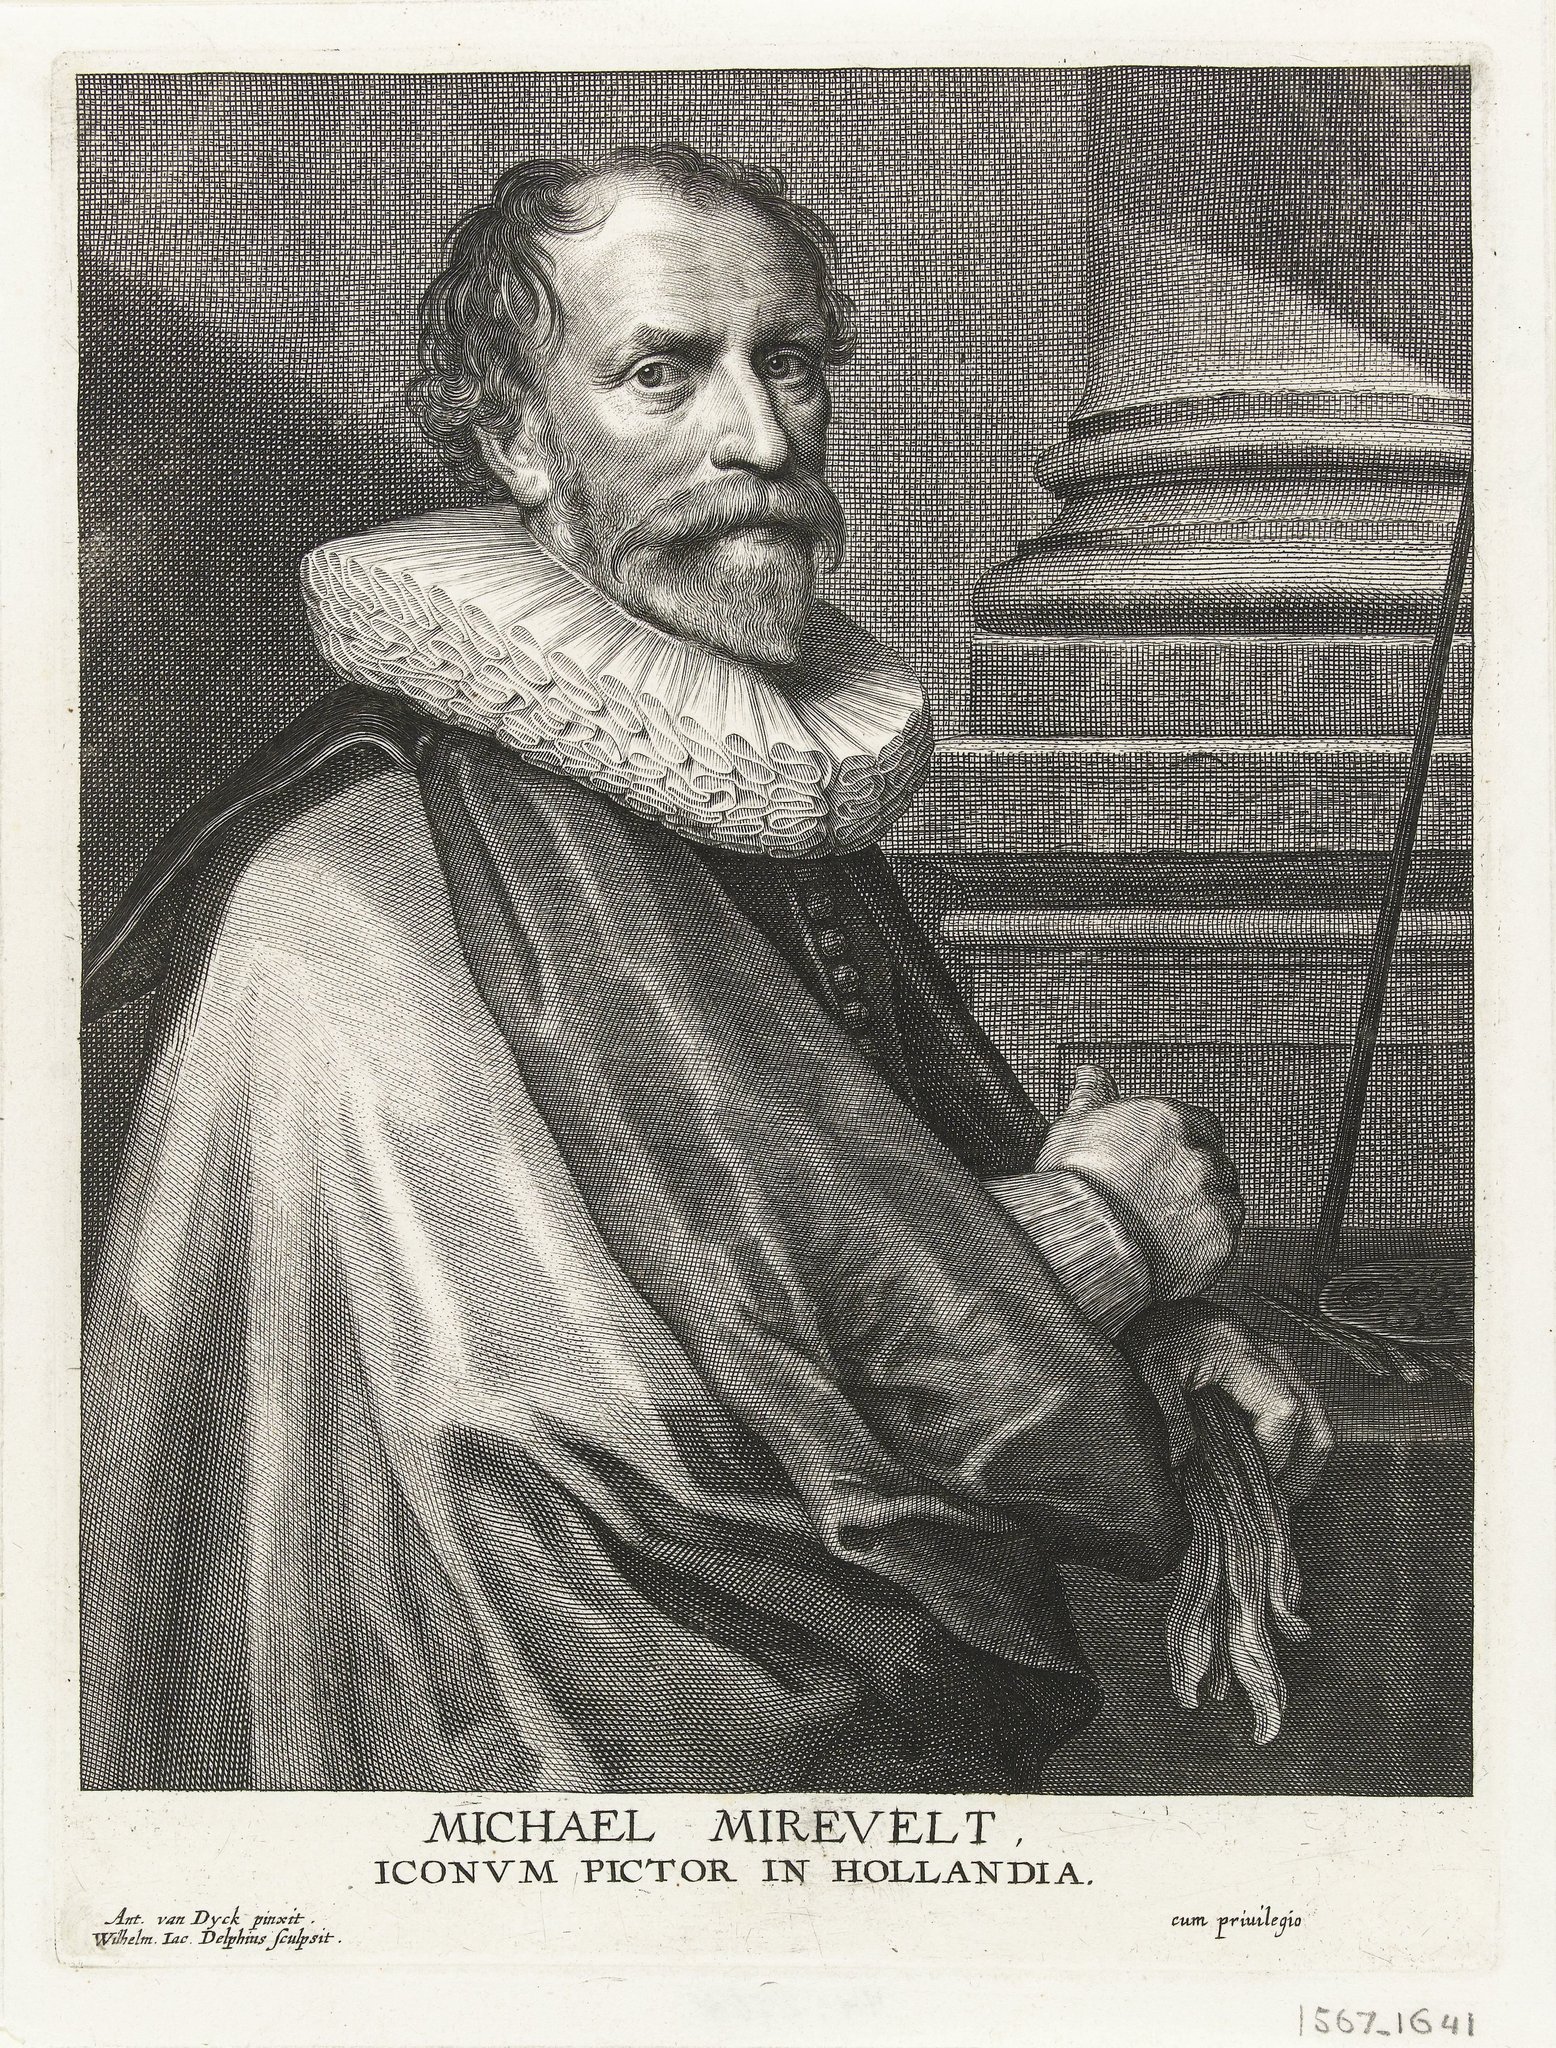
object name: print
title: Portret van Michiel Jansz. van Mierevelt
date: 1610-1625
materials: paper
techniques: engraving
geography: delft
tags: delft, painter, draughtsman, michiel jansz van mierevelt, portrait, self-portrait of painter, tools, implements of painter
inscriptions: collector's mark: Lugt 964, collector's mark: Lugt 2228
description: Portret van schilder Michiel Jansz. van Mierevelt, staand ten halven lijve met plooikraag en mantel, in zijn handen een paar handschoenen. Op tafel een schilderspalet, kwasten en schildersstok.